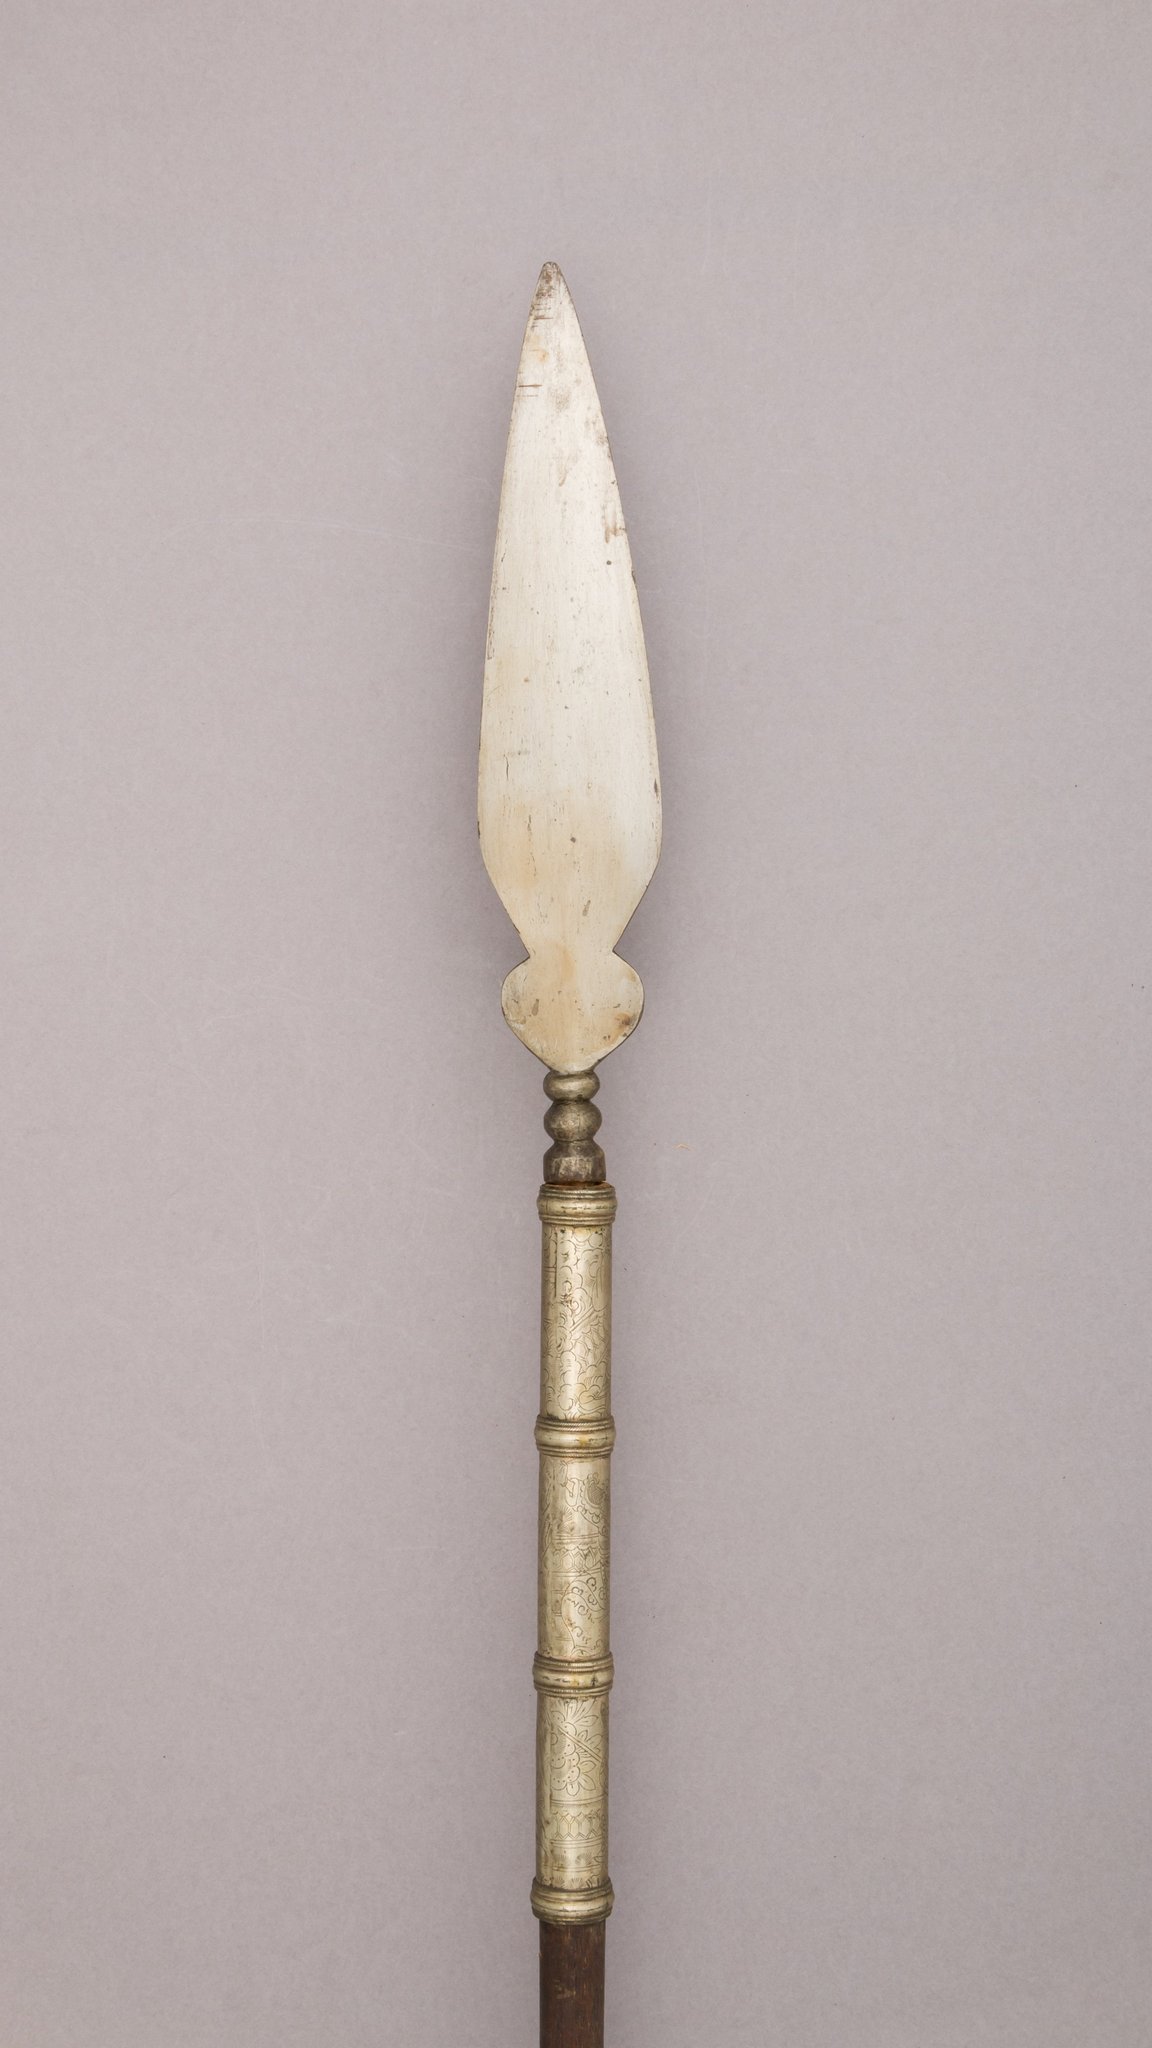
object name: spear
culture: philippine, jolo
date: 1701-1900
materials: silver, steel, wood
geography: philippines